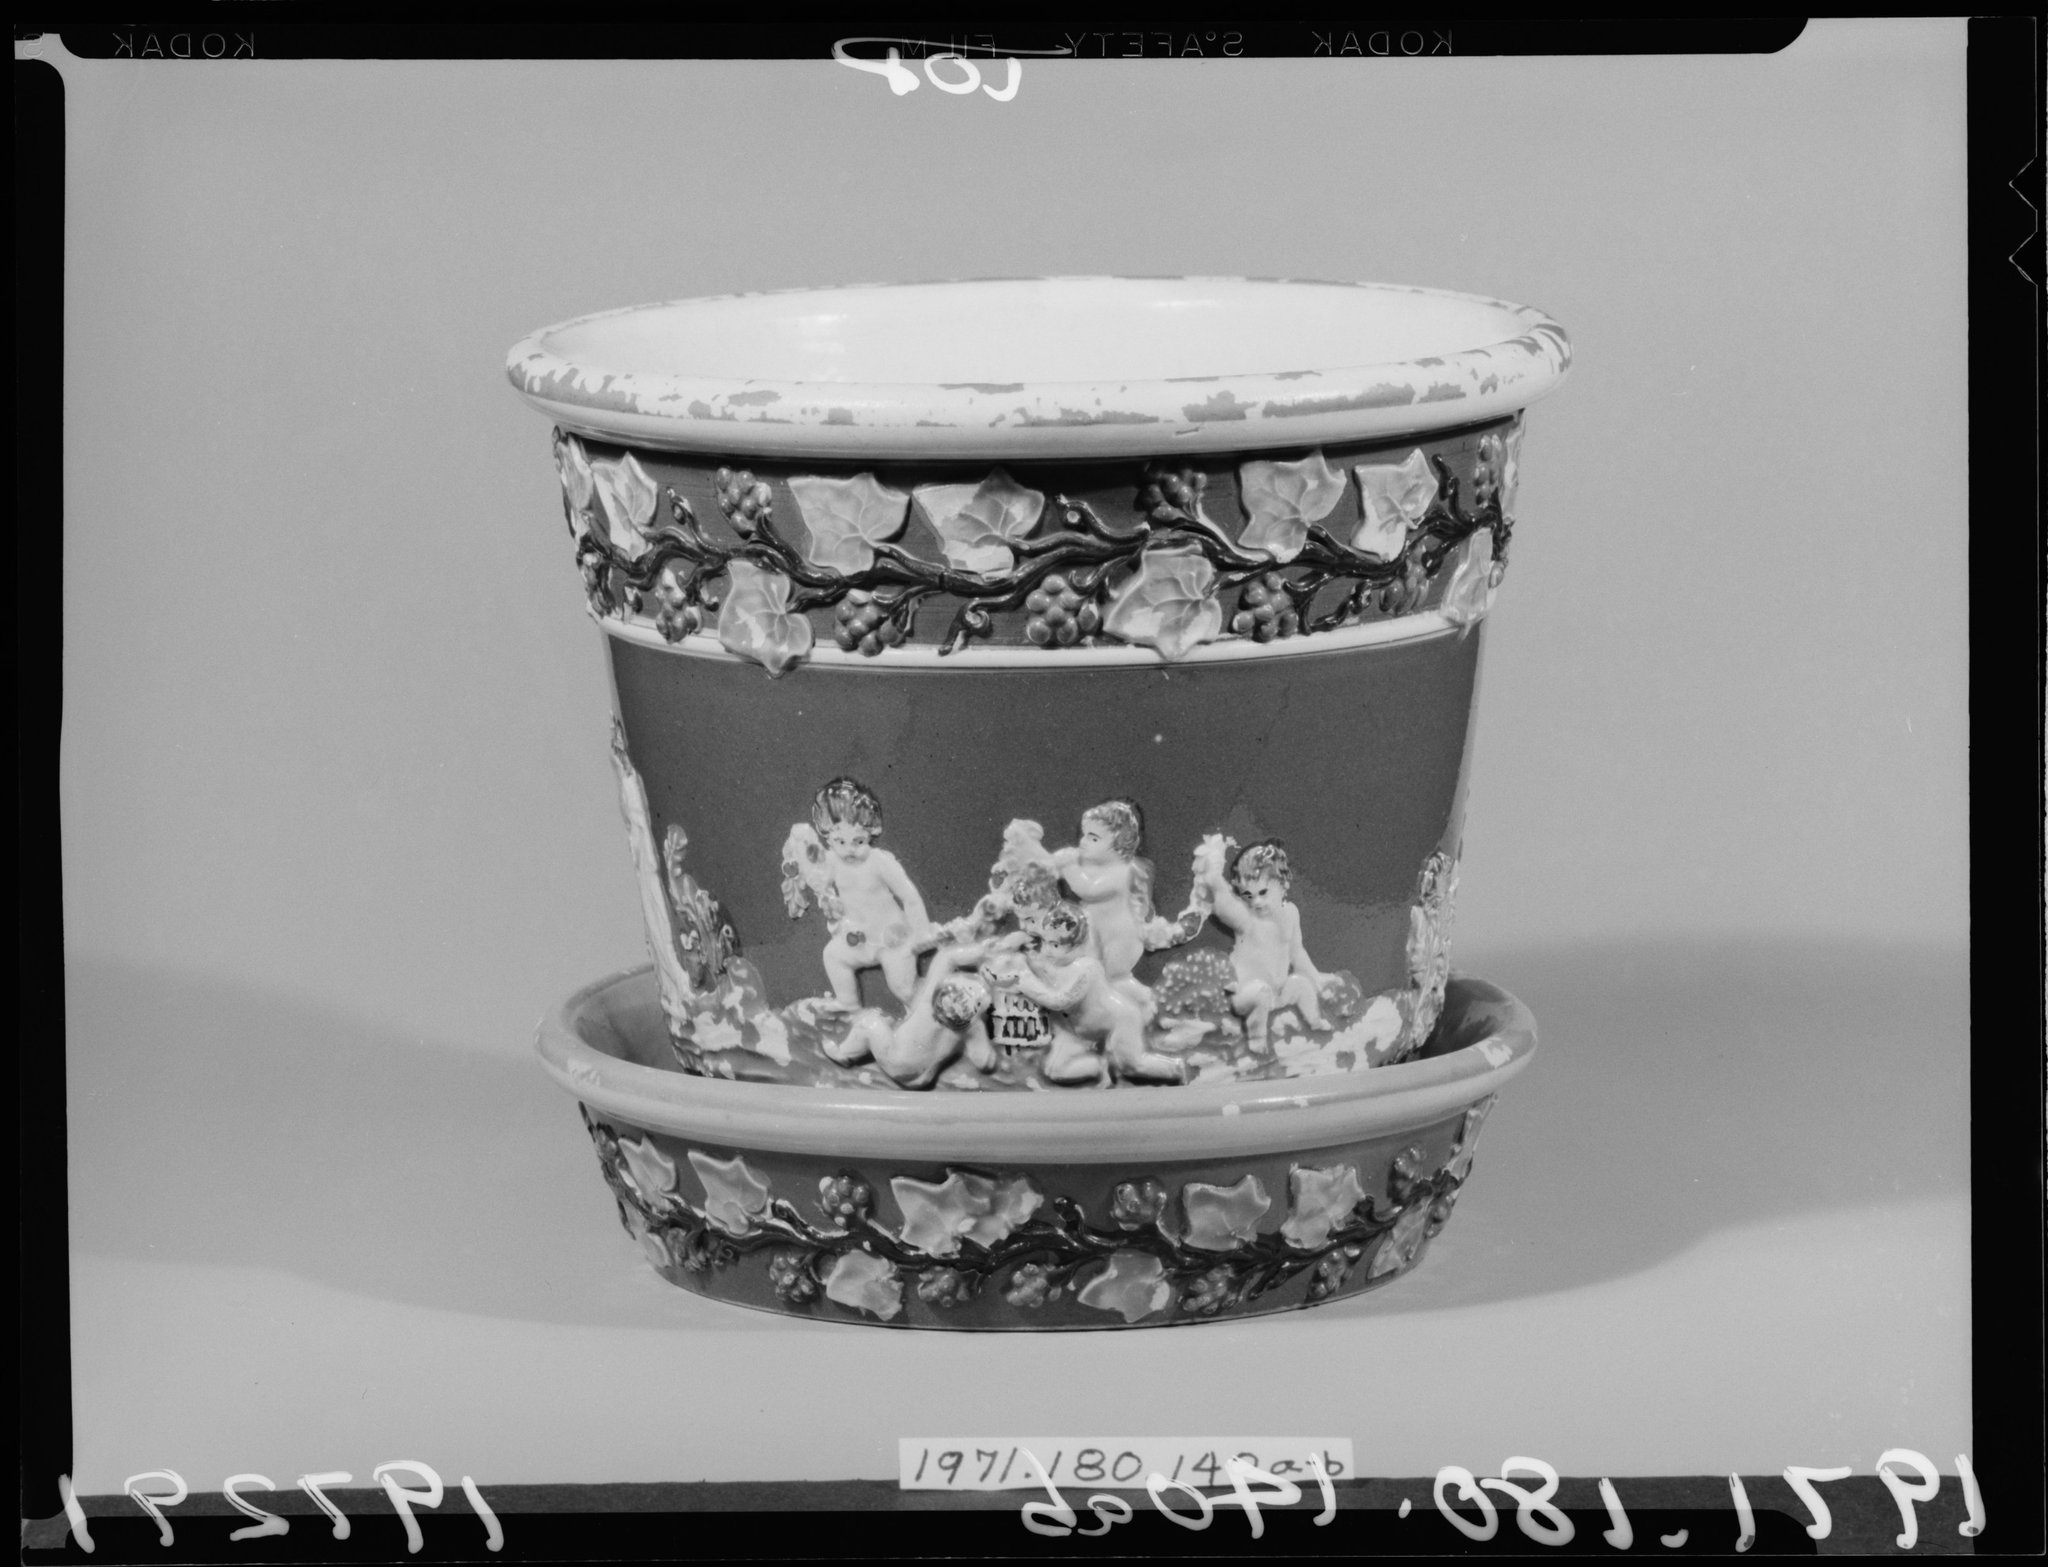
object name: cachepot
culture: british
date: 1775-1800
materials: earthenware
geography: england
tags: grapes,children